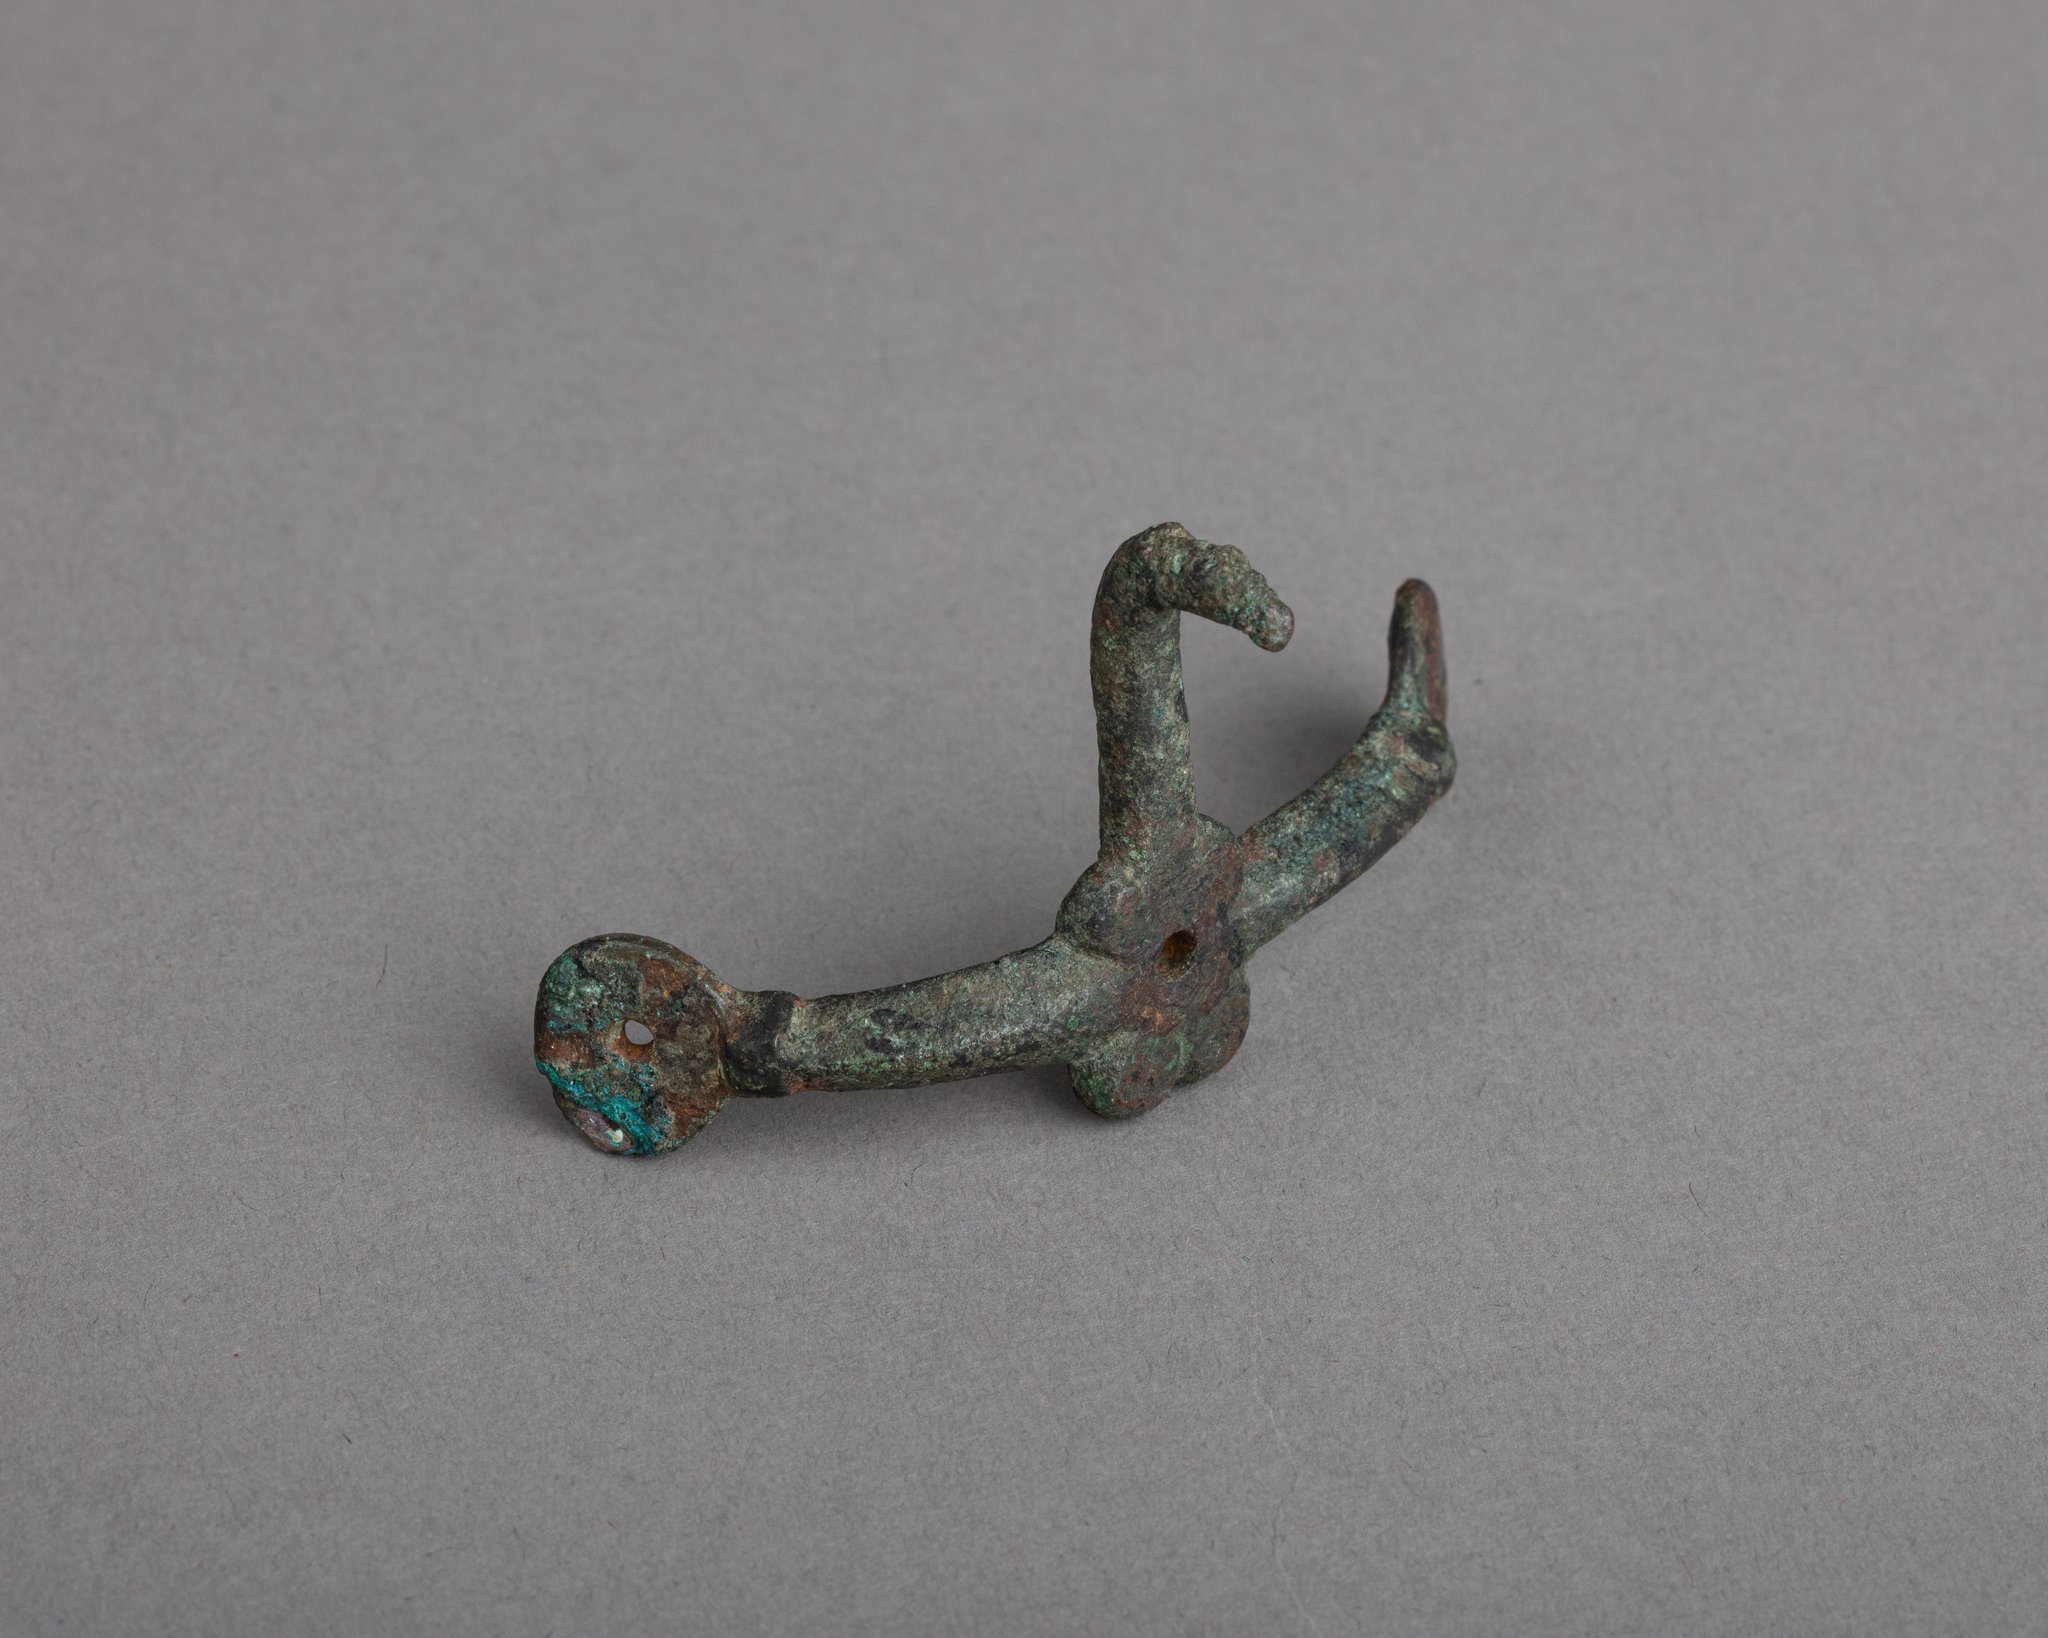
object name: spur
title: Prick Spur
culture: british-roman or gallo-roman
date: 101-400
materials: copper alloy, iron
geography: united kingdom